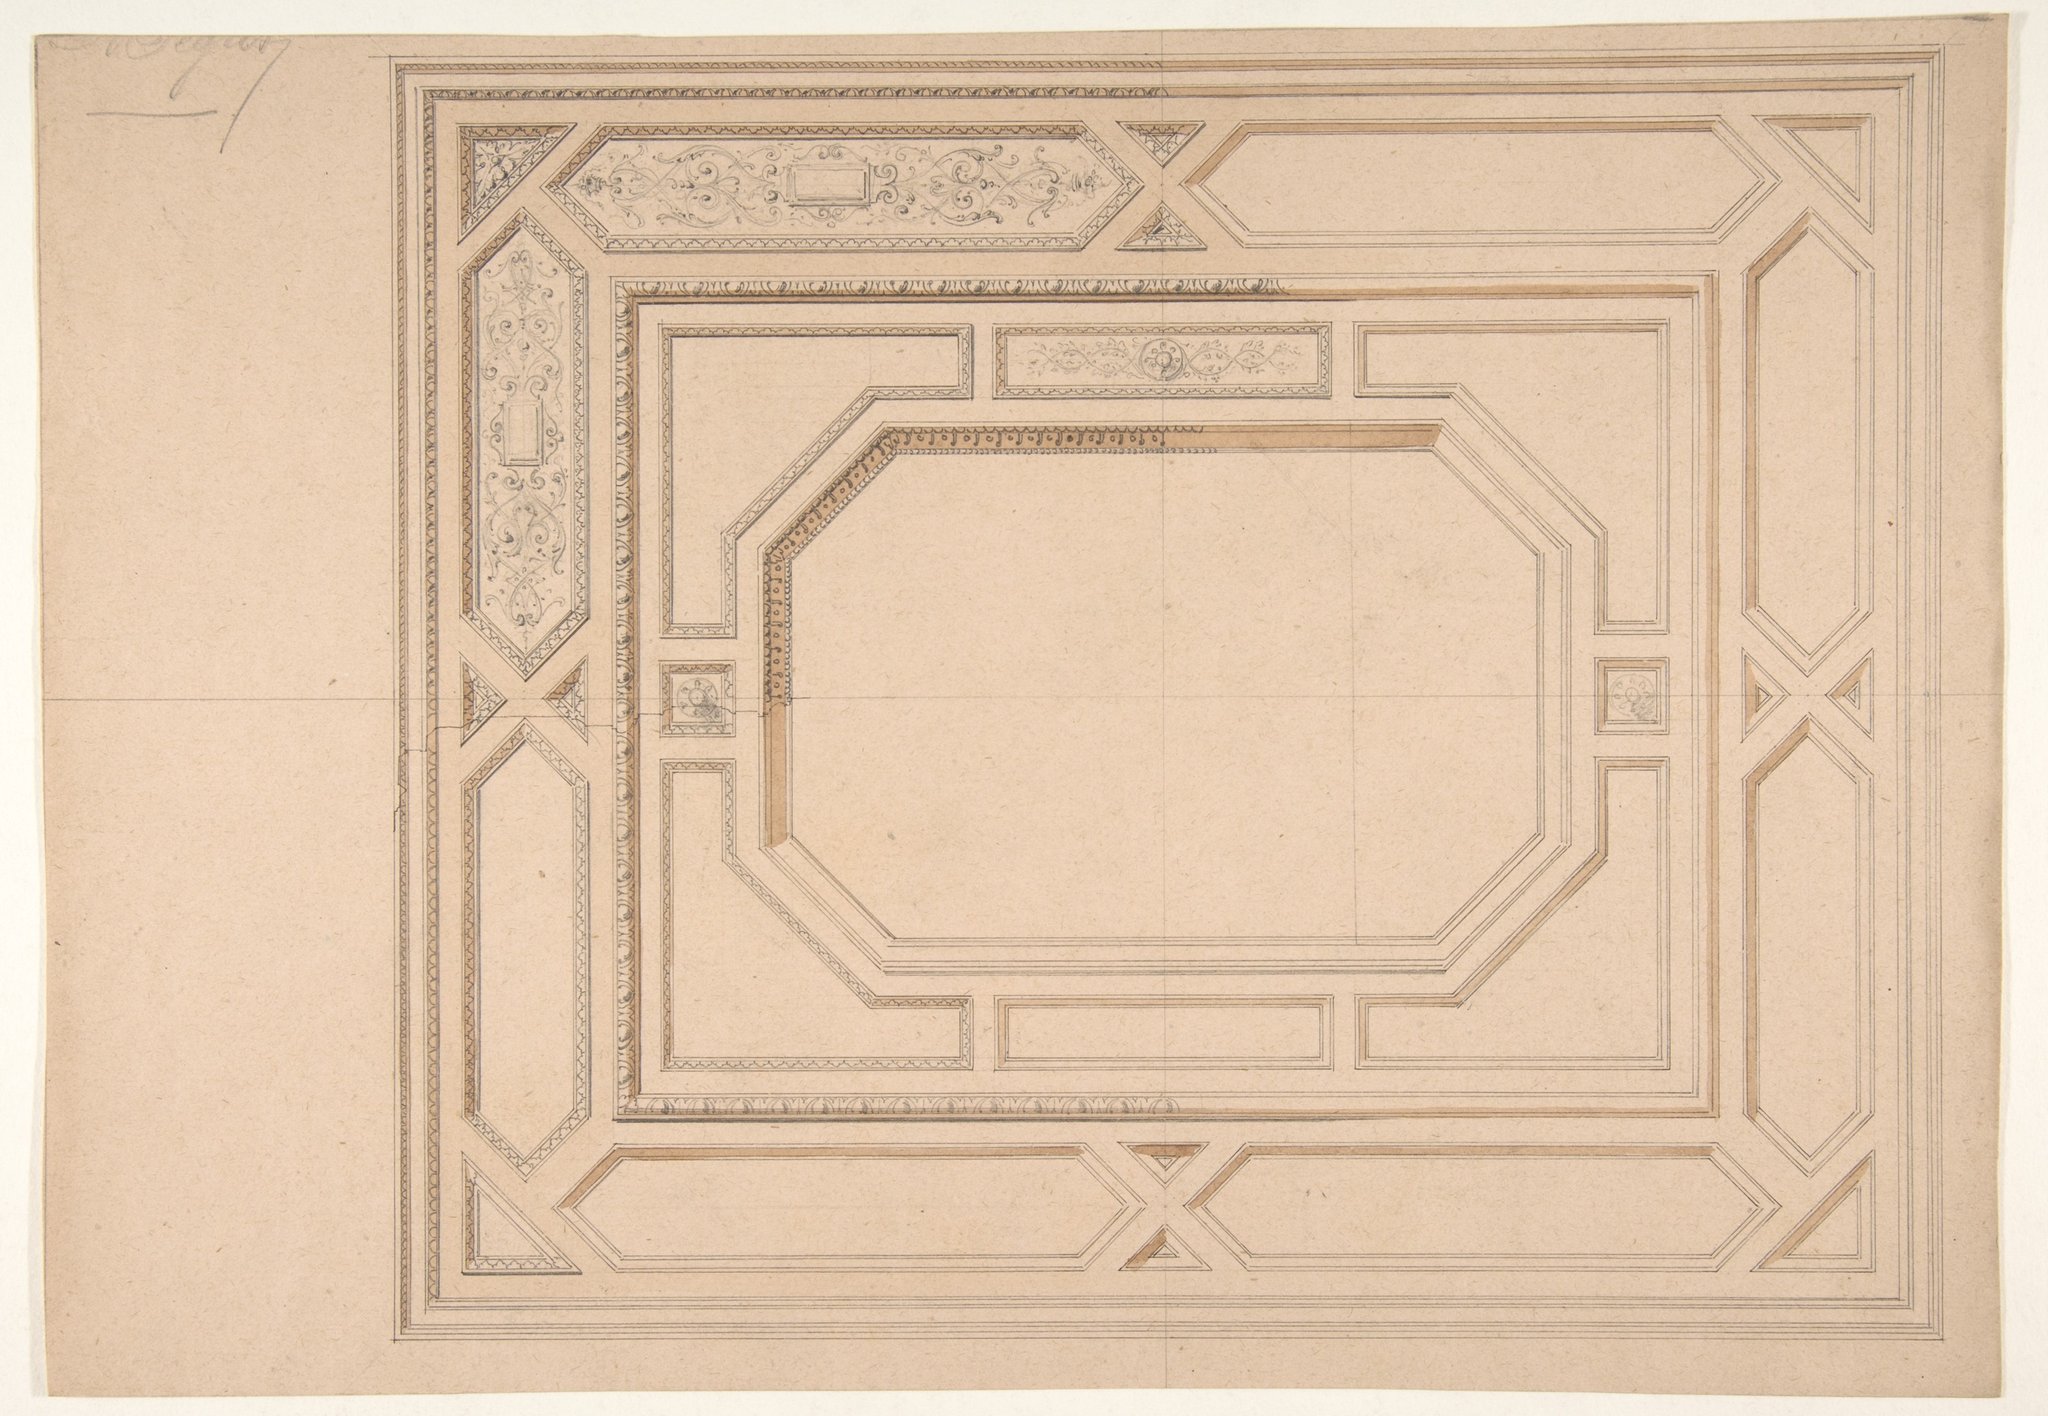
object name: drawing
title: Design for a ceiling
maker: jules-edmond-charles lachaise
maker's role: artist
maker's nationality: french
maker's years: 1897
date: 1851-1900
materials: graphite, ink, watercolor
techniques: pen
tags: ceilings